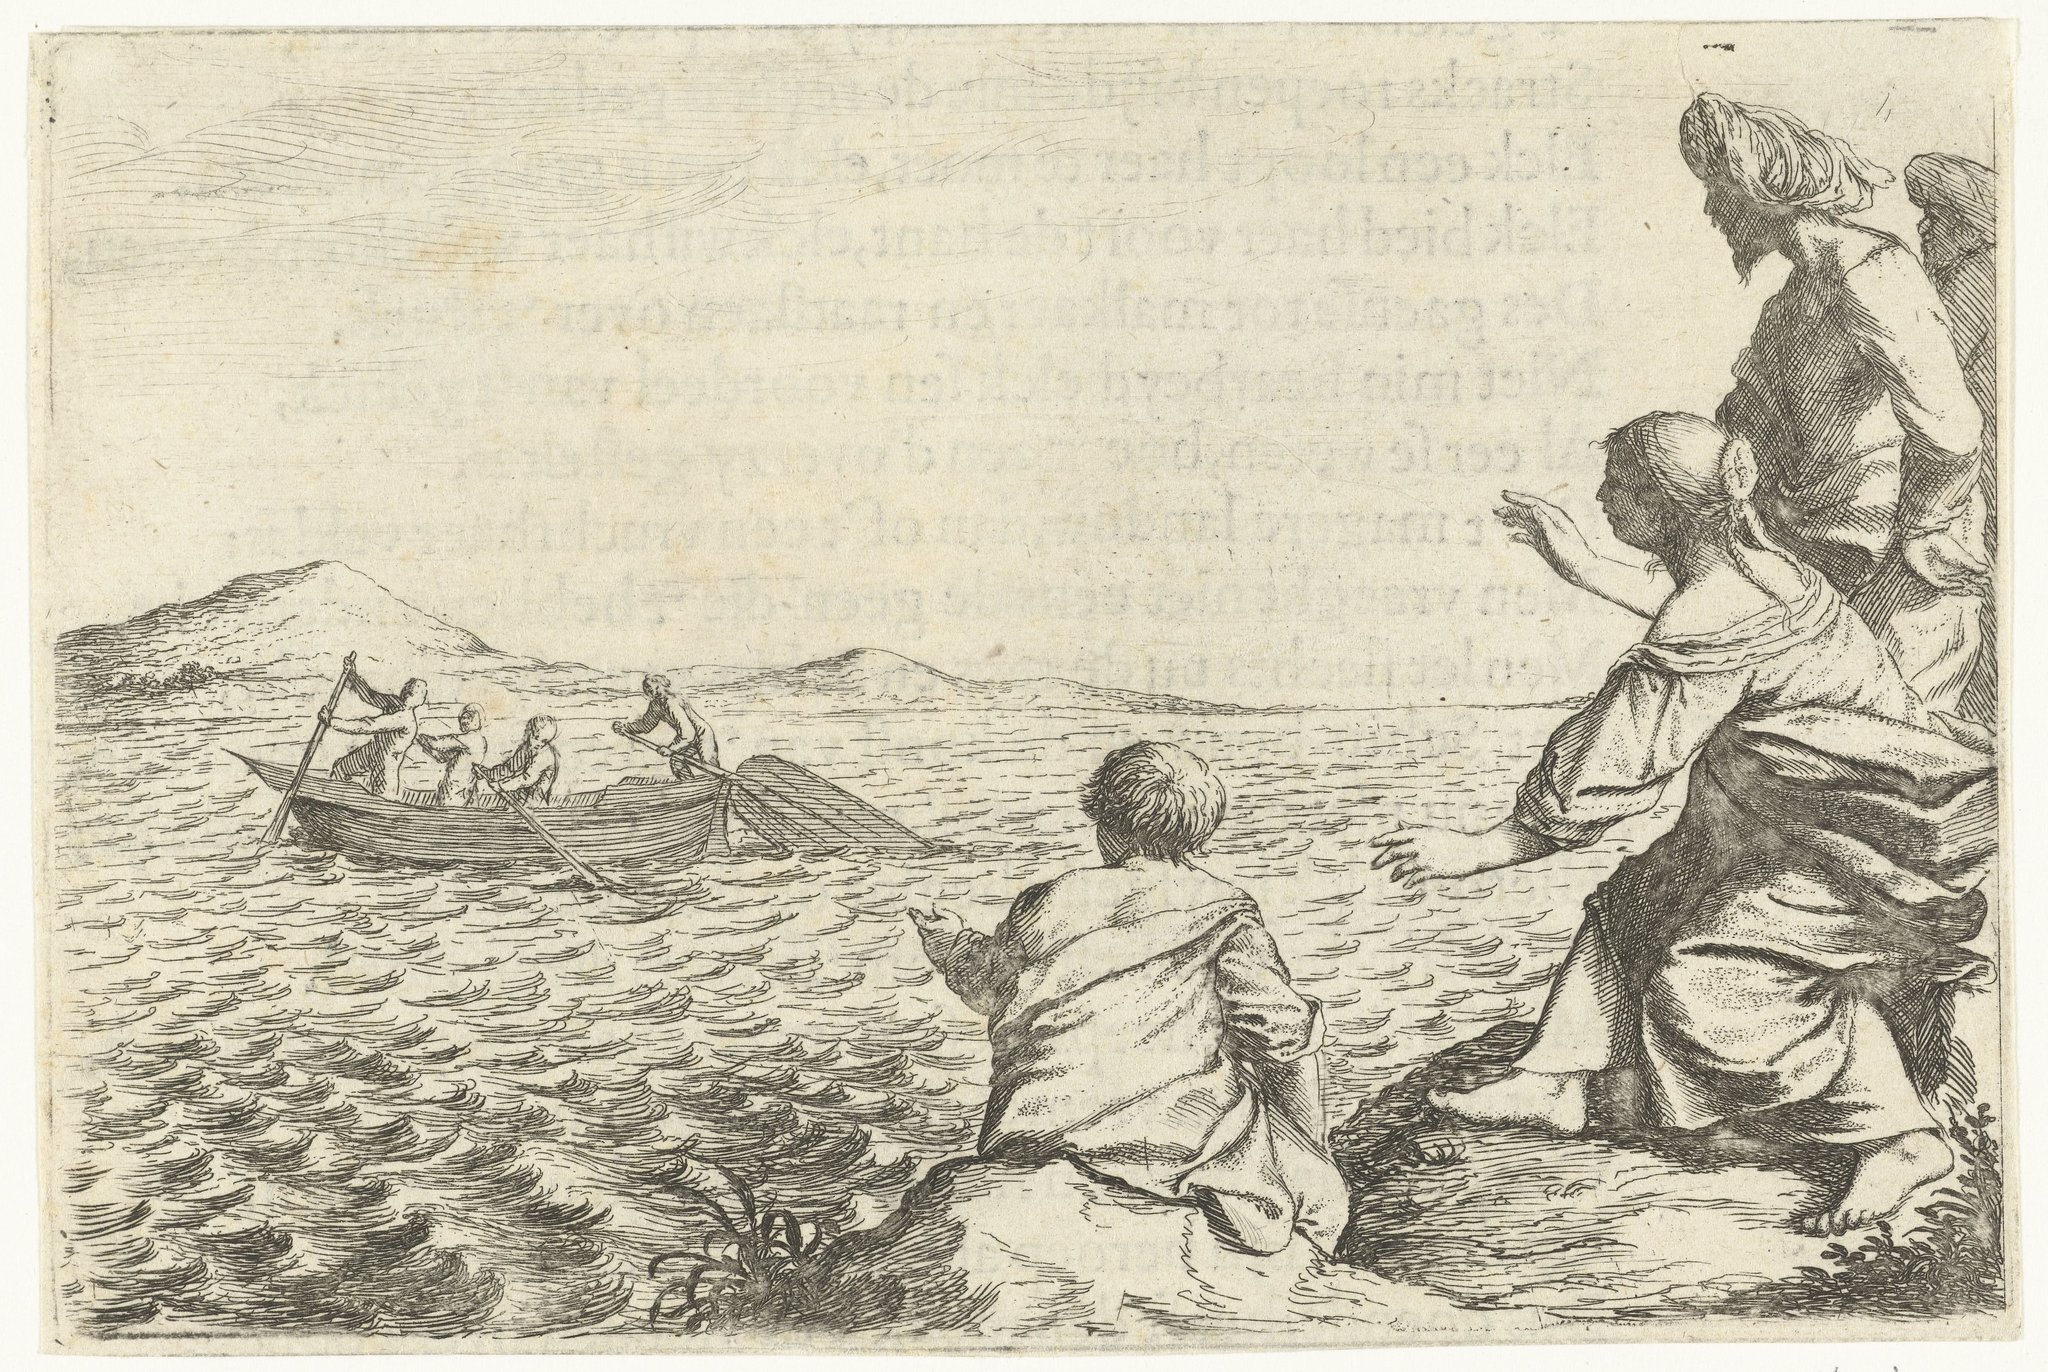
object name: print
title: Afstammelingen van Noach vinden de roer uit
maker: willem basse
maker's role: draughtsman, print maker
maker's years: 1613-1672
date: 1632-1634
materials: paper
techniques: engraving, etching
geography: northern netherlands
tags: parts of ship's exterior: rudder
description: De afstammelingen van Noach vinden de roer uit waarmee een bootje gestuurd en in bedwang gehouden kan worden. Bedrukt op achterzijde met tekst in het Nederlands.